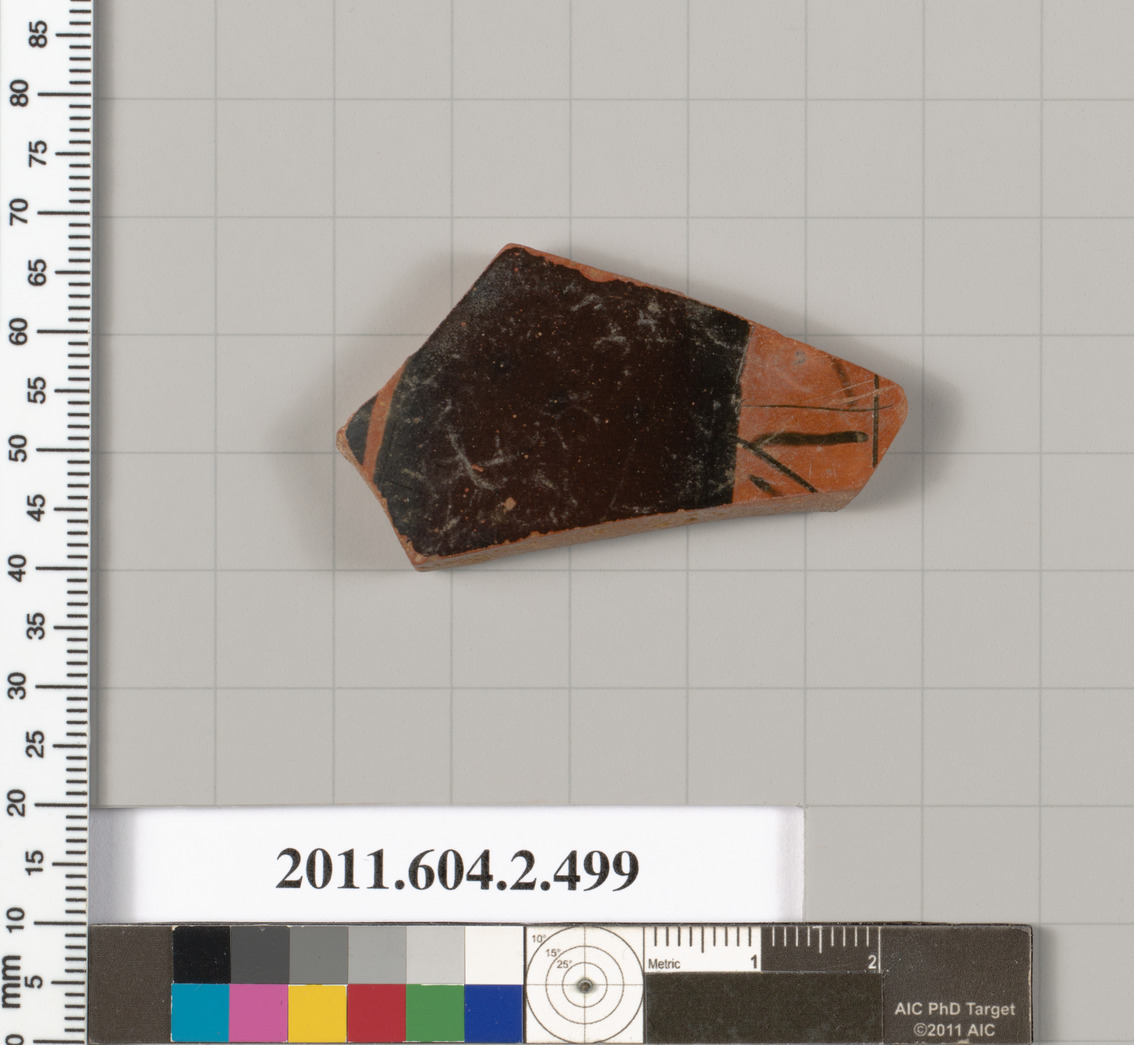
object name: column krater fragment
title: Terracotta fragment of a column-krater (bowl for mixing wine and water)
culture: greek, attic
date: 460-440 BCE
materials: terracotta